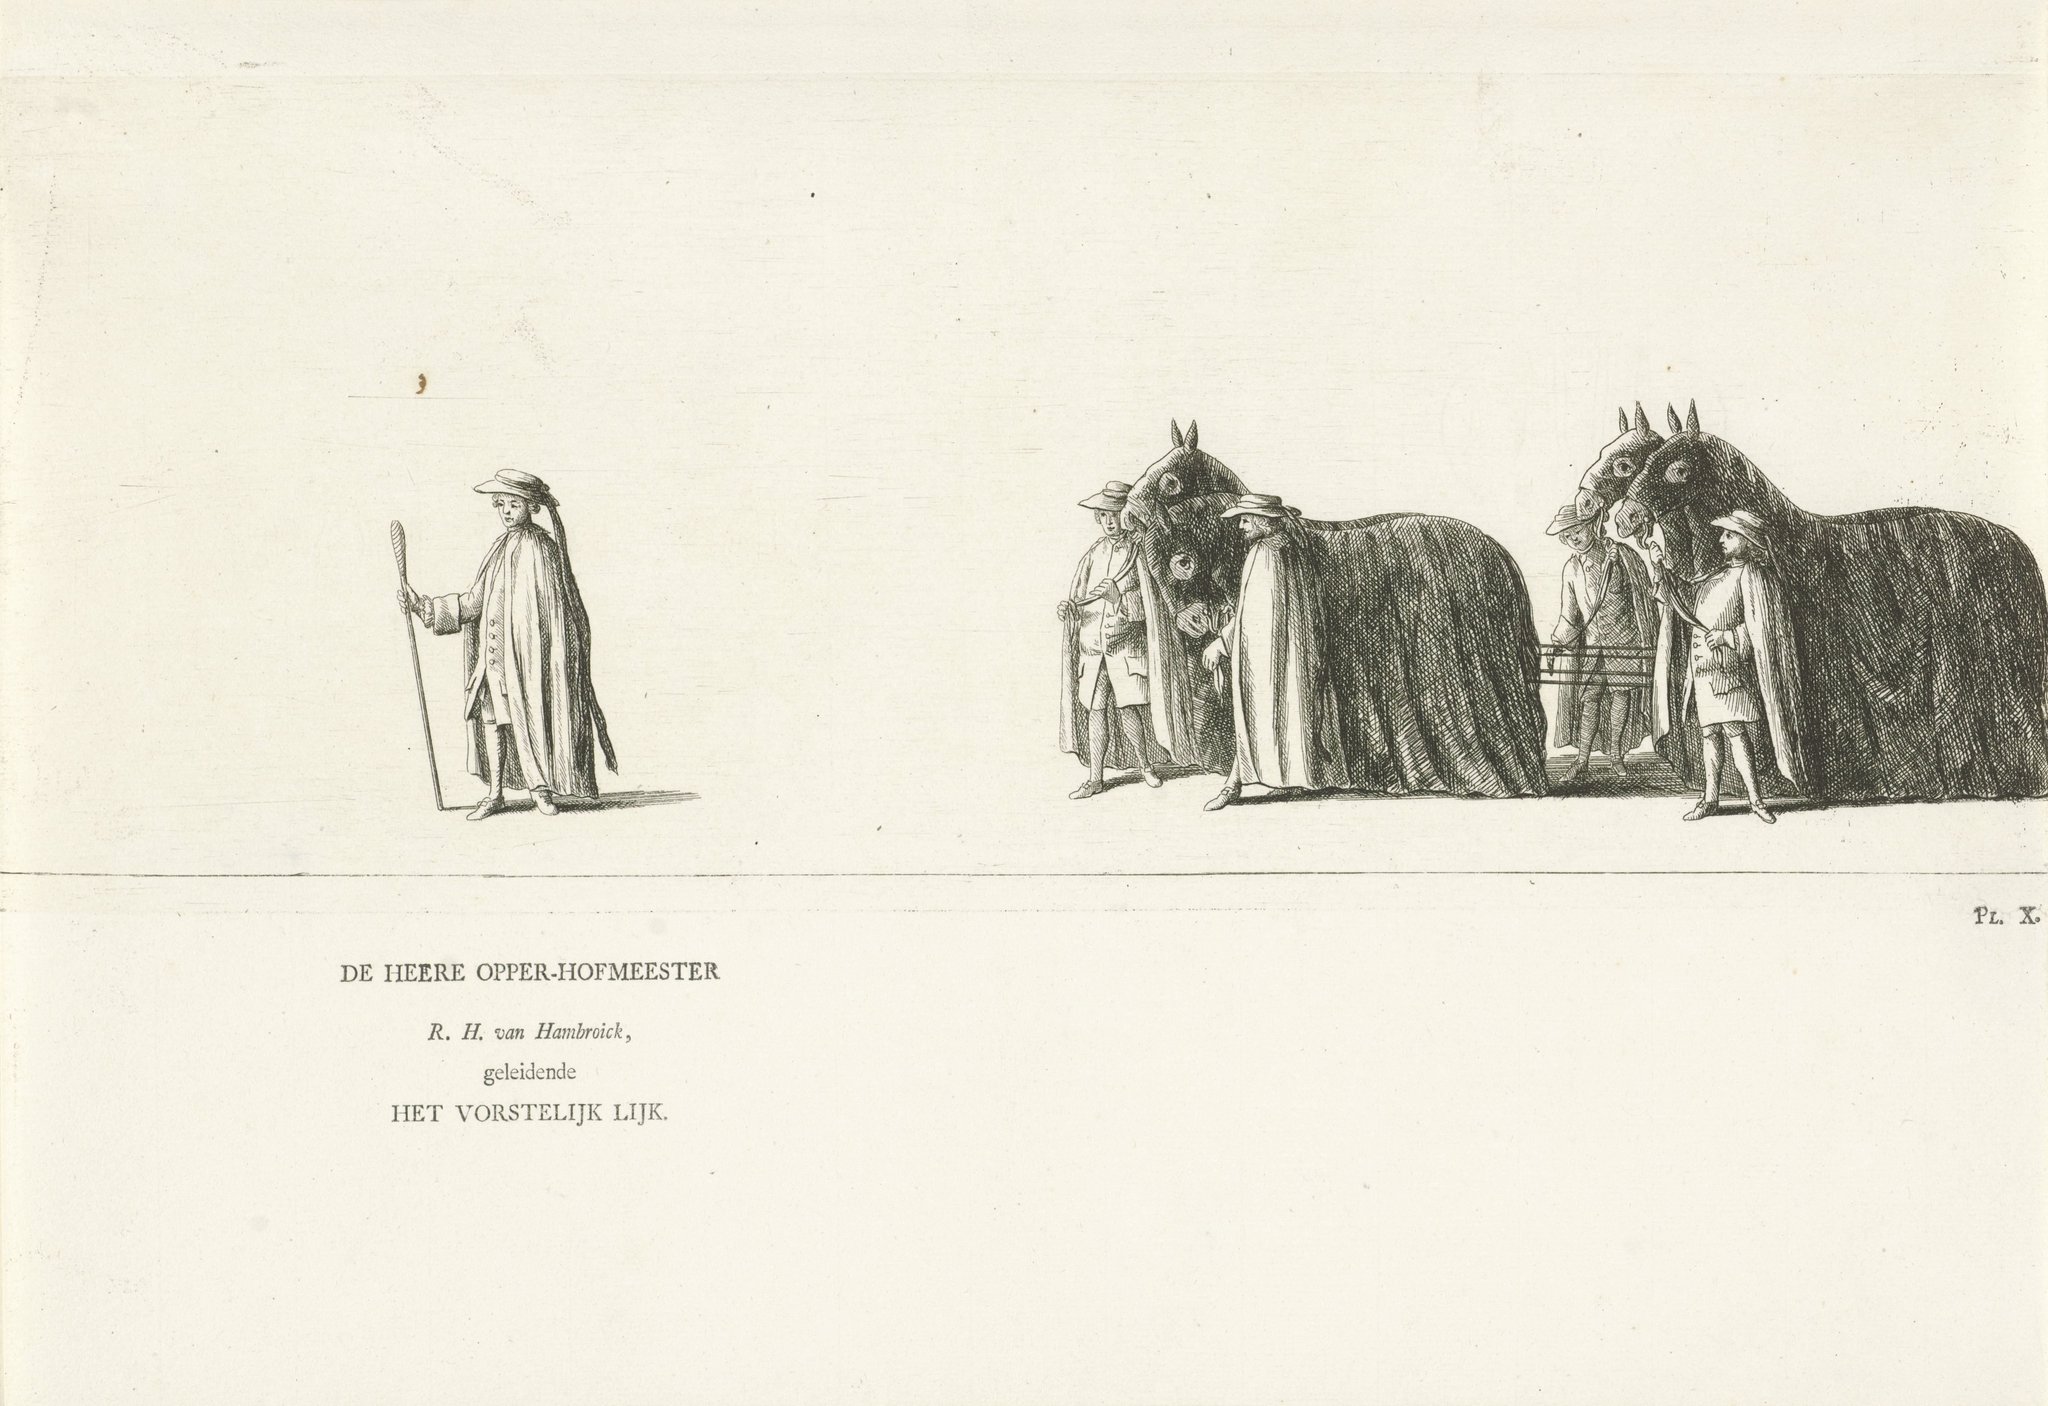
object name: print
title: Lijkstatie van prinses Maria Louise, 1765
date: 1765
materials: paper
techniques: etching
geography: leeuwarden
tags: funeral carriages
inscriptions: collector's mark: Lugt 2228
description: De eerste twee spannen paarden voor de lijkwagen van de prinses. Gemerkt rechtsonder: Pl. X. Op het blad onder de plaat de naam van een persoon in de stoet. Onderdeel van de serie platen van de begrafenis van prinses Maria Louise te Leeuwarden op 13 juni 1765.